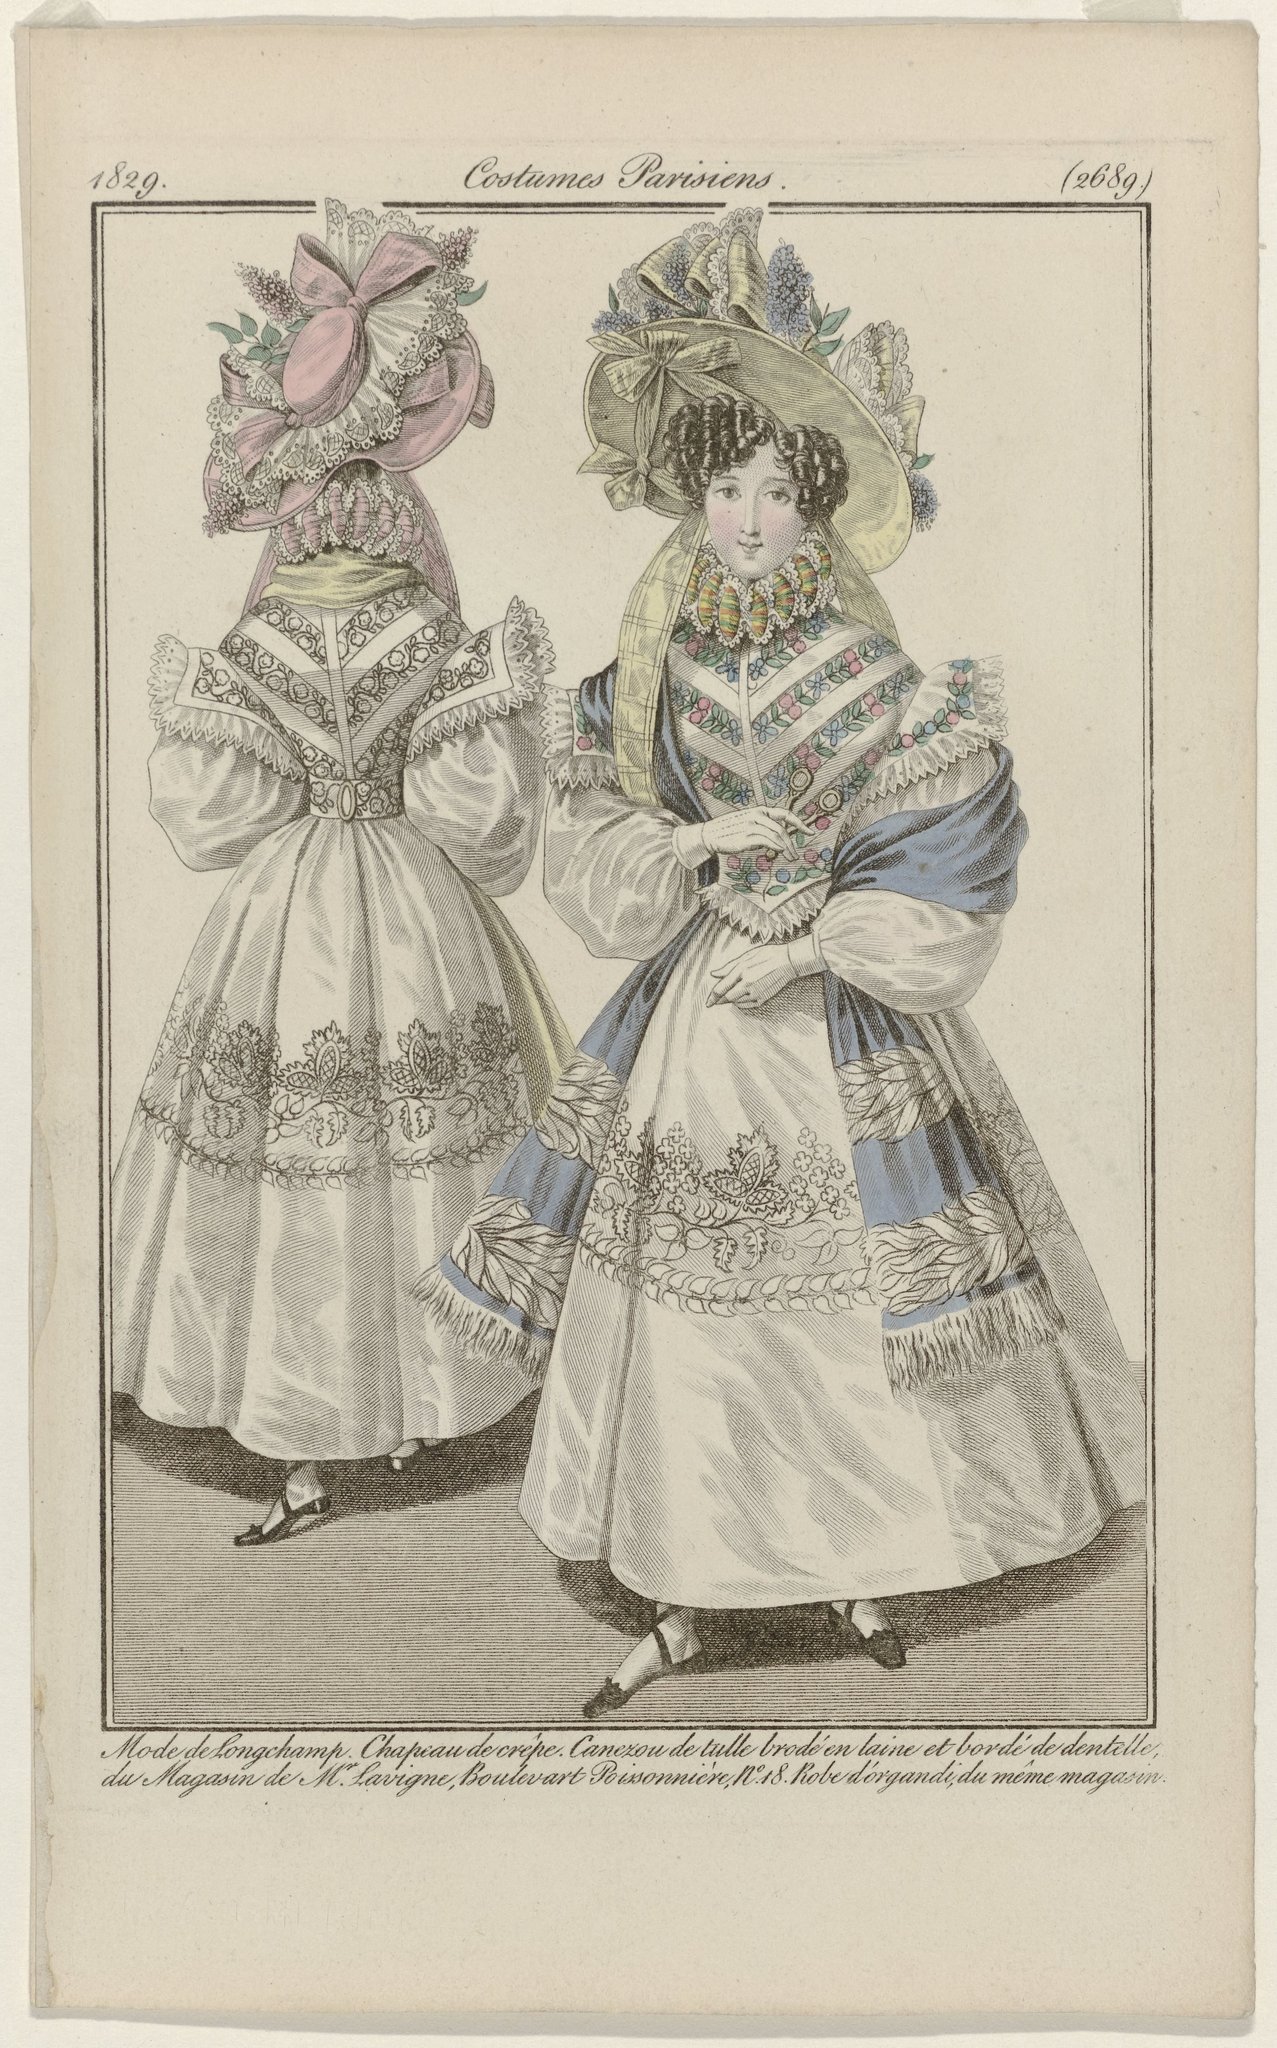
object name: fashion print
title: Journal des Dames et des Modes, Costumes Parisiens, 25 avril 1829, (2689): Mode de Longchamp (...)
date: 1829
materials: paper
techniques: engraving, hand coloring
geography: paris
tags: embroidery (ornamentation) (+ women's clothes), clothing for the upper part of the body: blouse (+ women's clothes), lace (+ women's clothes), eyeglasses, spectacles (+ female (human being) (not to be used where -aa- is prescribed)), fashion plates, head-gear: hat (+ women's clothes), shoes, sandals (+ women's clothes), gloves, mittens, etc. (+ women's clothes), dress, gown (+ women's clothes)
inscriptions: title: ‘Costumes Parisiens.’, caption: ‘Mode de Longchamp. Chapeau de crêpe. Canezou de tulle brodé en laine et bordé de dentelle, du Magasin de M.r Lavigne, Boulevart Poissonnière, No. 18. Robe d'rgandi, du même magasin.’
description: 'Mode de Longchamp.' Hoed van crêpe. 'Canezou' van tule, geborduurd met wol en afgezet met kant, uit de winkel van Mr Lavigne. Japon van organdie, uit dezelfde winkel. Verdere accessoires: handschoenen, lorgnet, sjaal afgezet met franjes, platte schoenen met banden. De prent maakt deel uit van het modetijdschrift Journal des Dames et des Modes, uitgegeven door Pierre de la Mésangère, Parijs, 1797-1839.